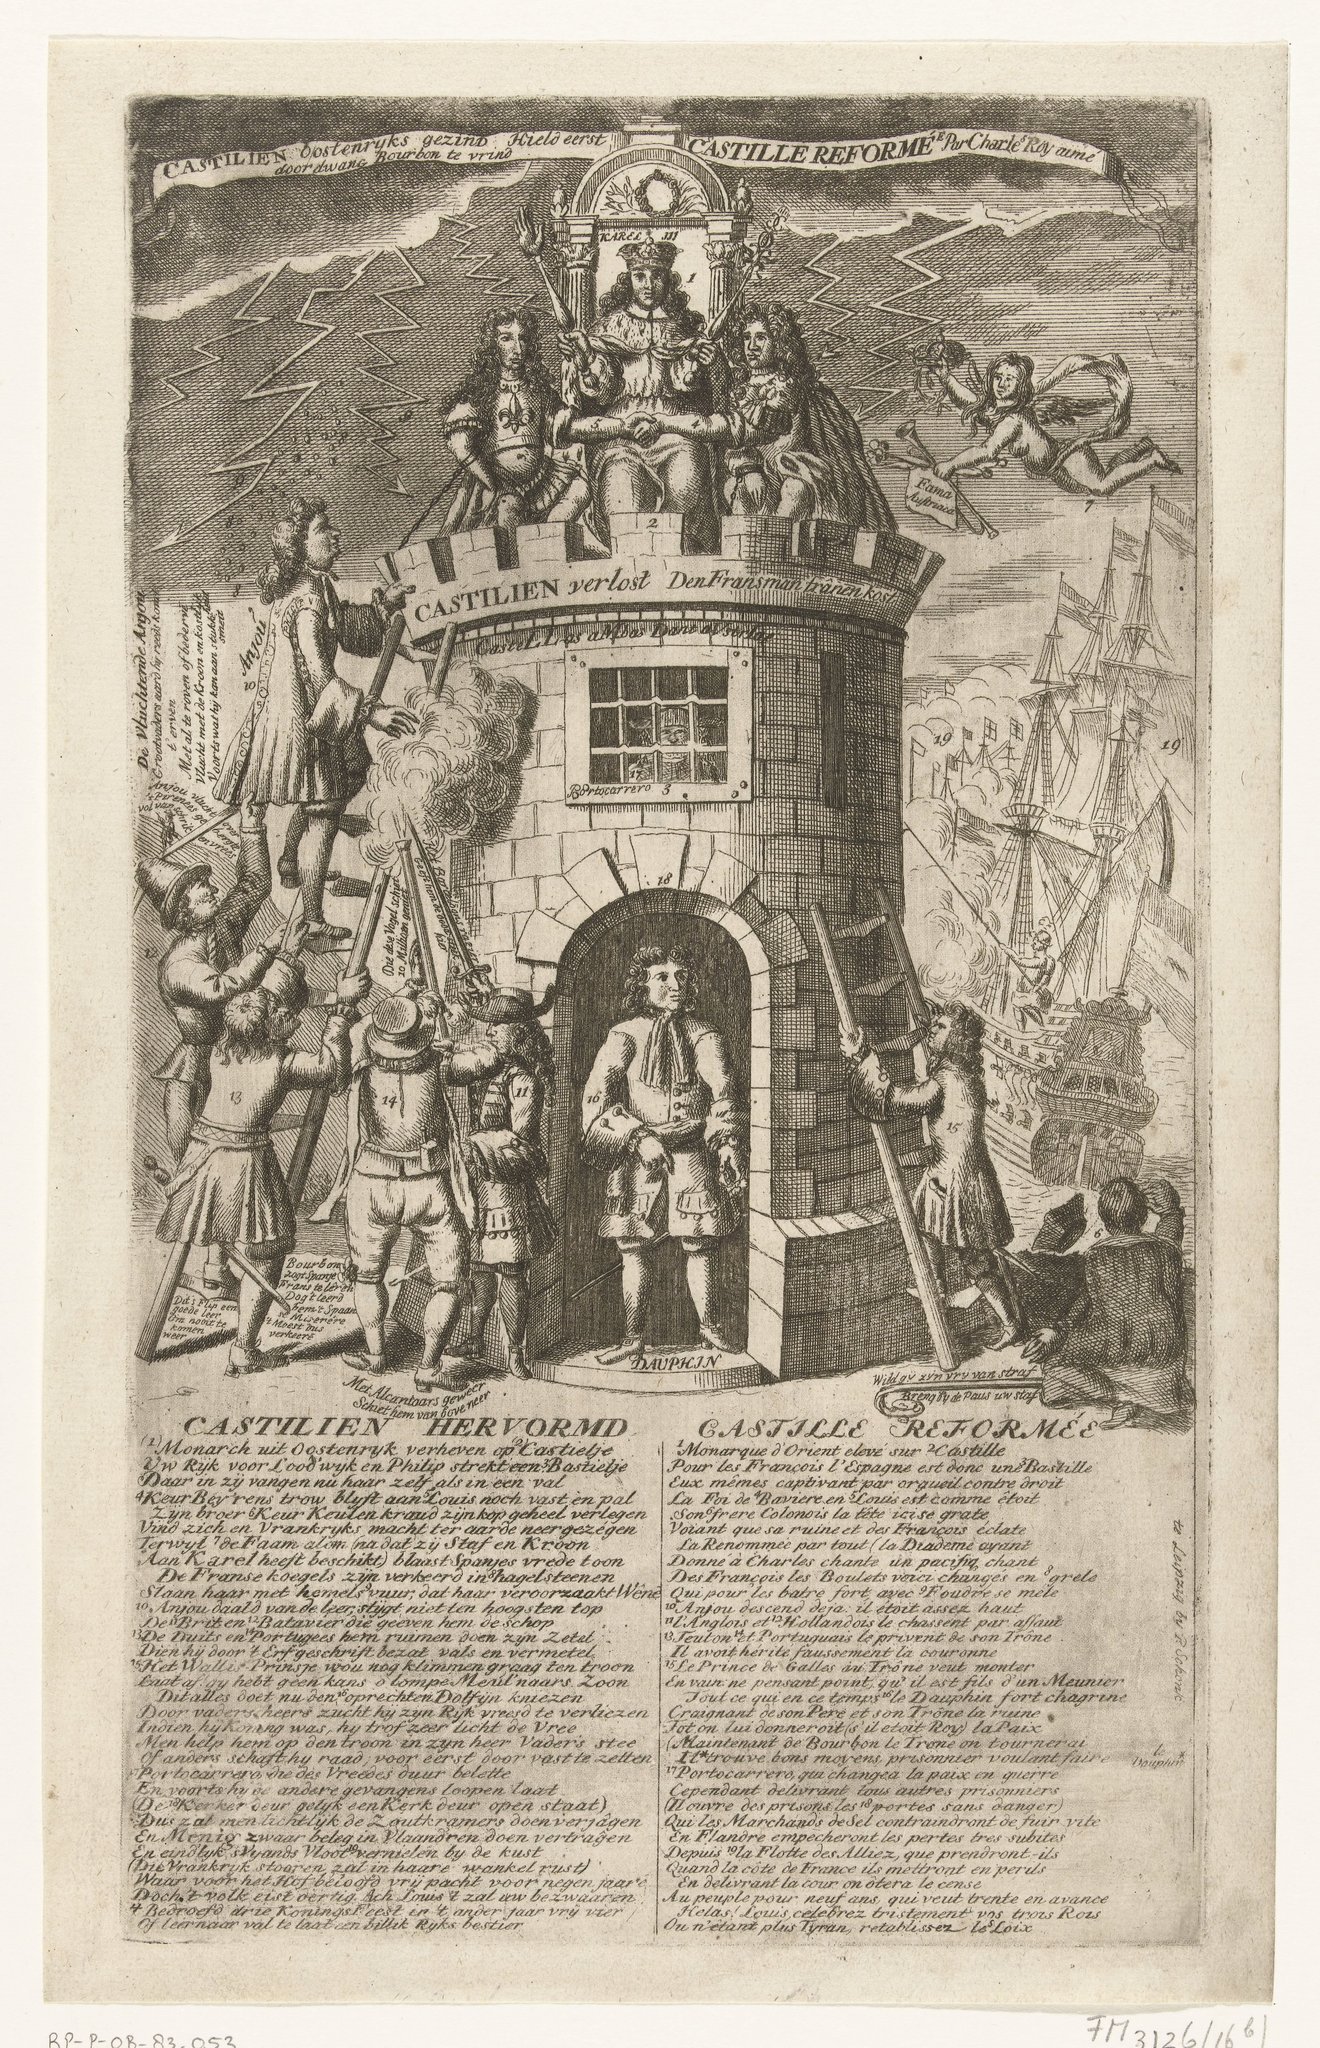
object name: cartoon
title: Castilien Hervormd / Castille reformée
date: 1706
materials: paper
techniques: etching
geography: amsterdam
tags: lodewijk xiv (koning van frankrijk), maximiliaan ii emanuel (keurvorst van beieren), vienna, charles vi (holy roman emperor), political caricatures and satires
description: Spotprent op de partijen vechtend om Castilië, 1706. Bovenop een kasteel zitten Karel III, de keurvorst van Beieren en Lodewijk XIV. Anderen proberen op de toren te klimmen. In de plaat verzen in het Nederlands en Frans. Spotprent op de situatie in het jaar 1706 in de Spaanse Successieoorlog. Onderdeel van een reeks van 25 spotprenten op de Fransen en bondgenoten uit het jaar 1706.